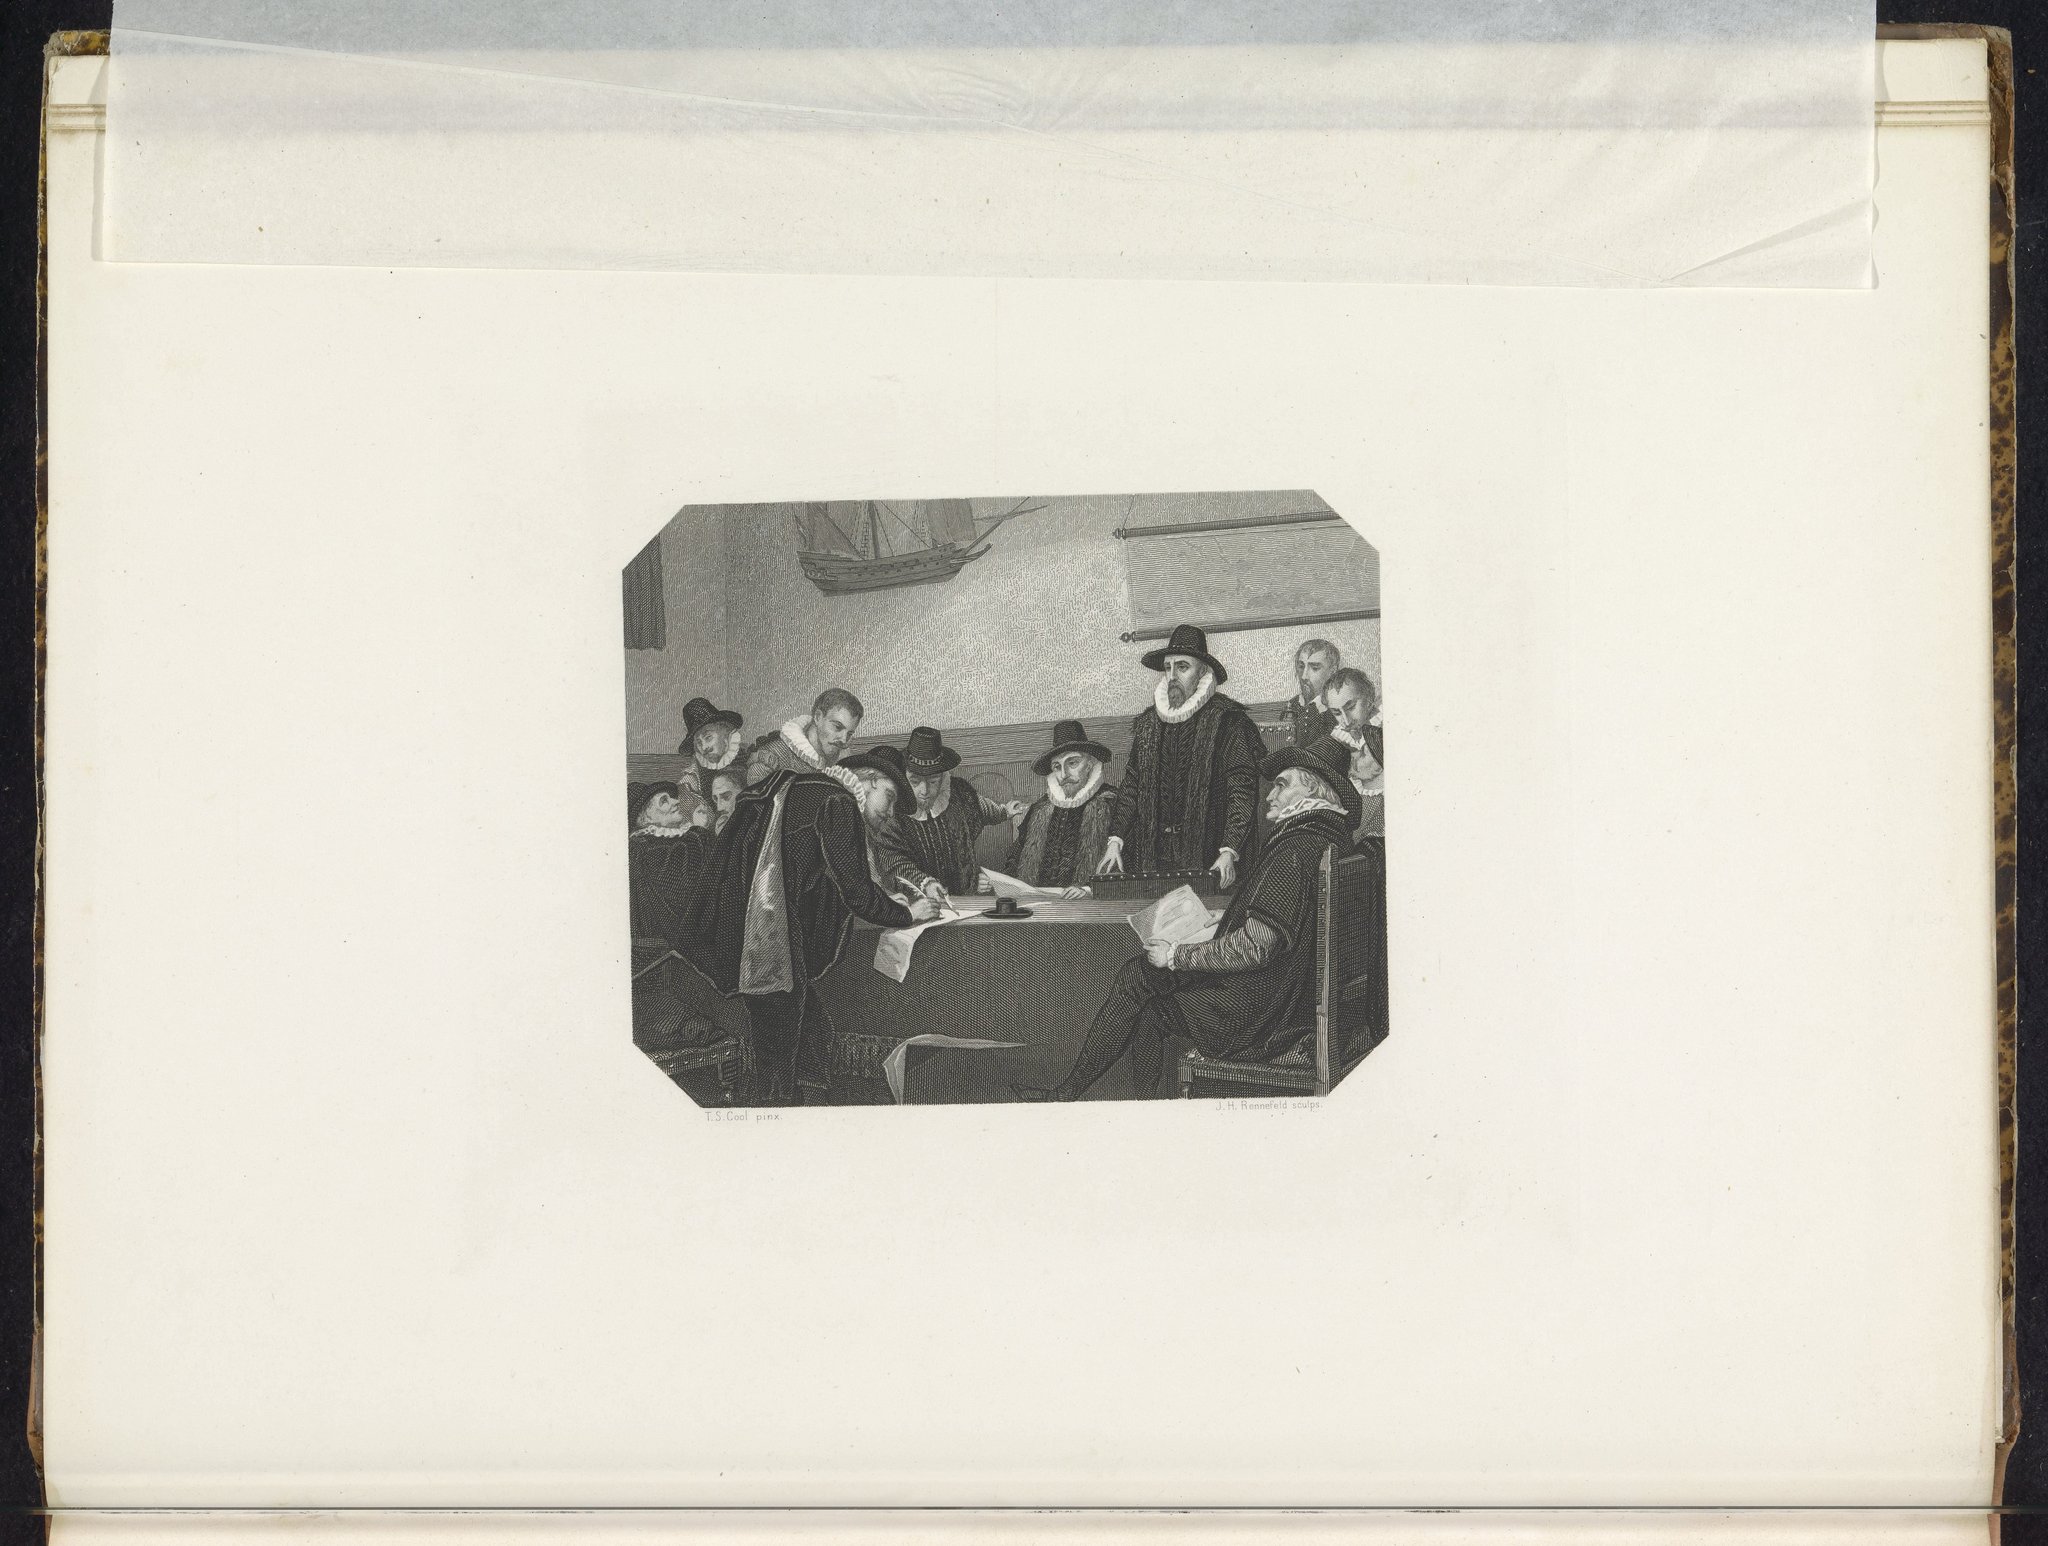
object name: history print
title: Oprichting van de VOC, 1602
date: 1865-1870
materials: paper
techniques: engraving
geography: netherlands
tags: the hague, johan van oldenbarnevelt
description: De oprichting van de Verenigde Oostindische Compagnie, januari 1602, in bijzijn van Johan van Oldenbarnevelt. Onderdeel van de groep staalgravures naar de schilderijen van de Historische Galerij der Maatschappij Arti et Amicitiae.